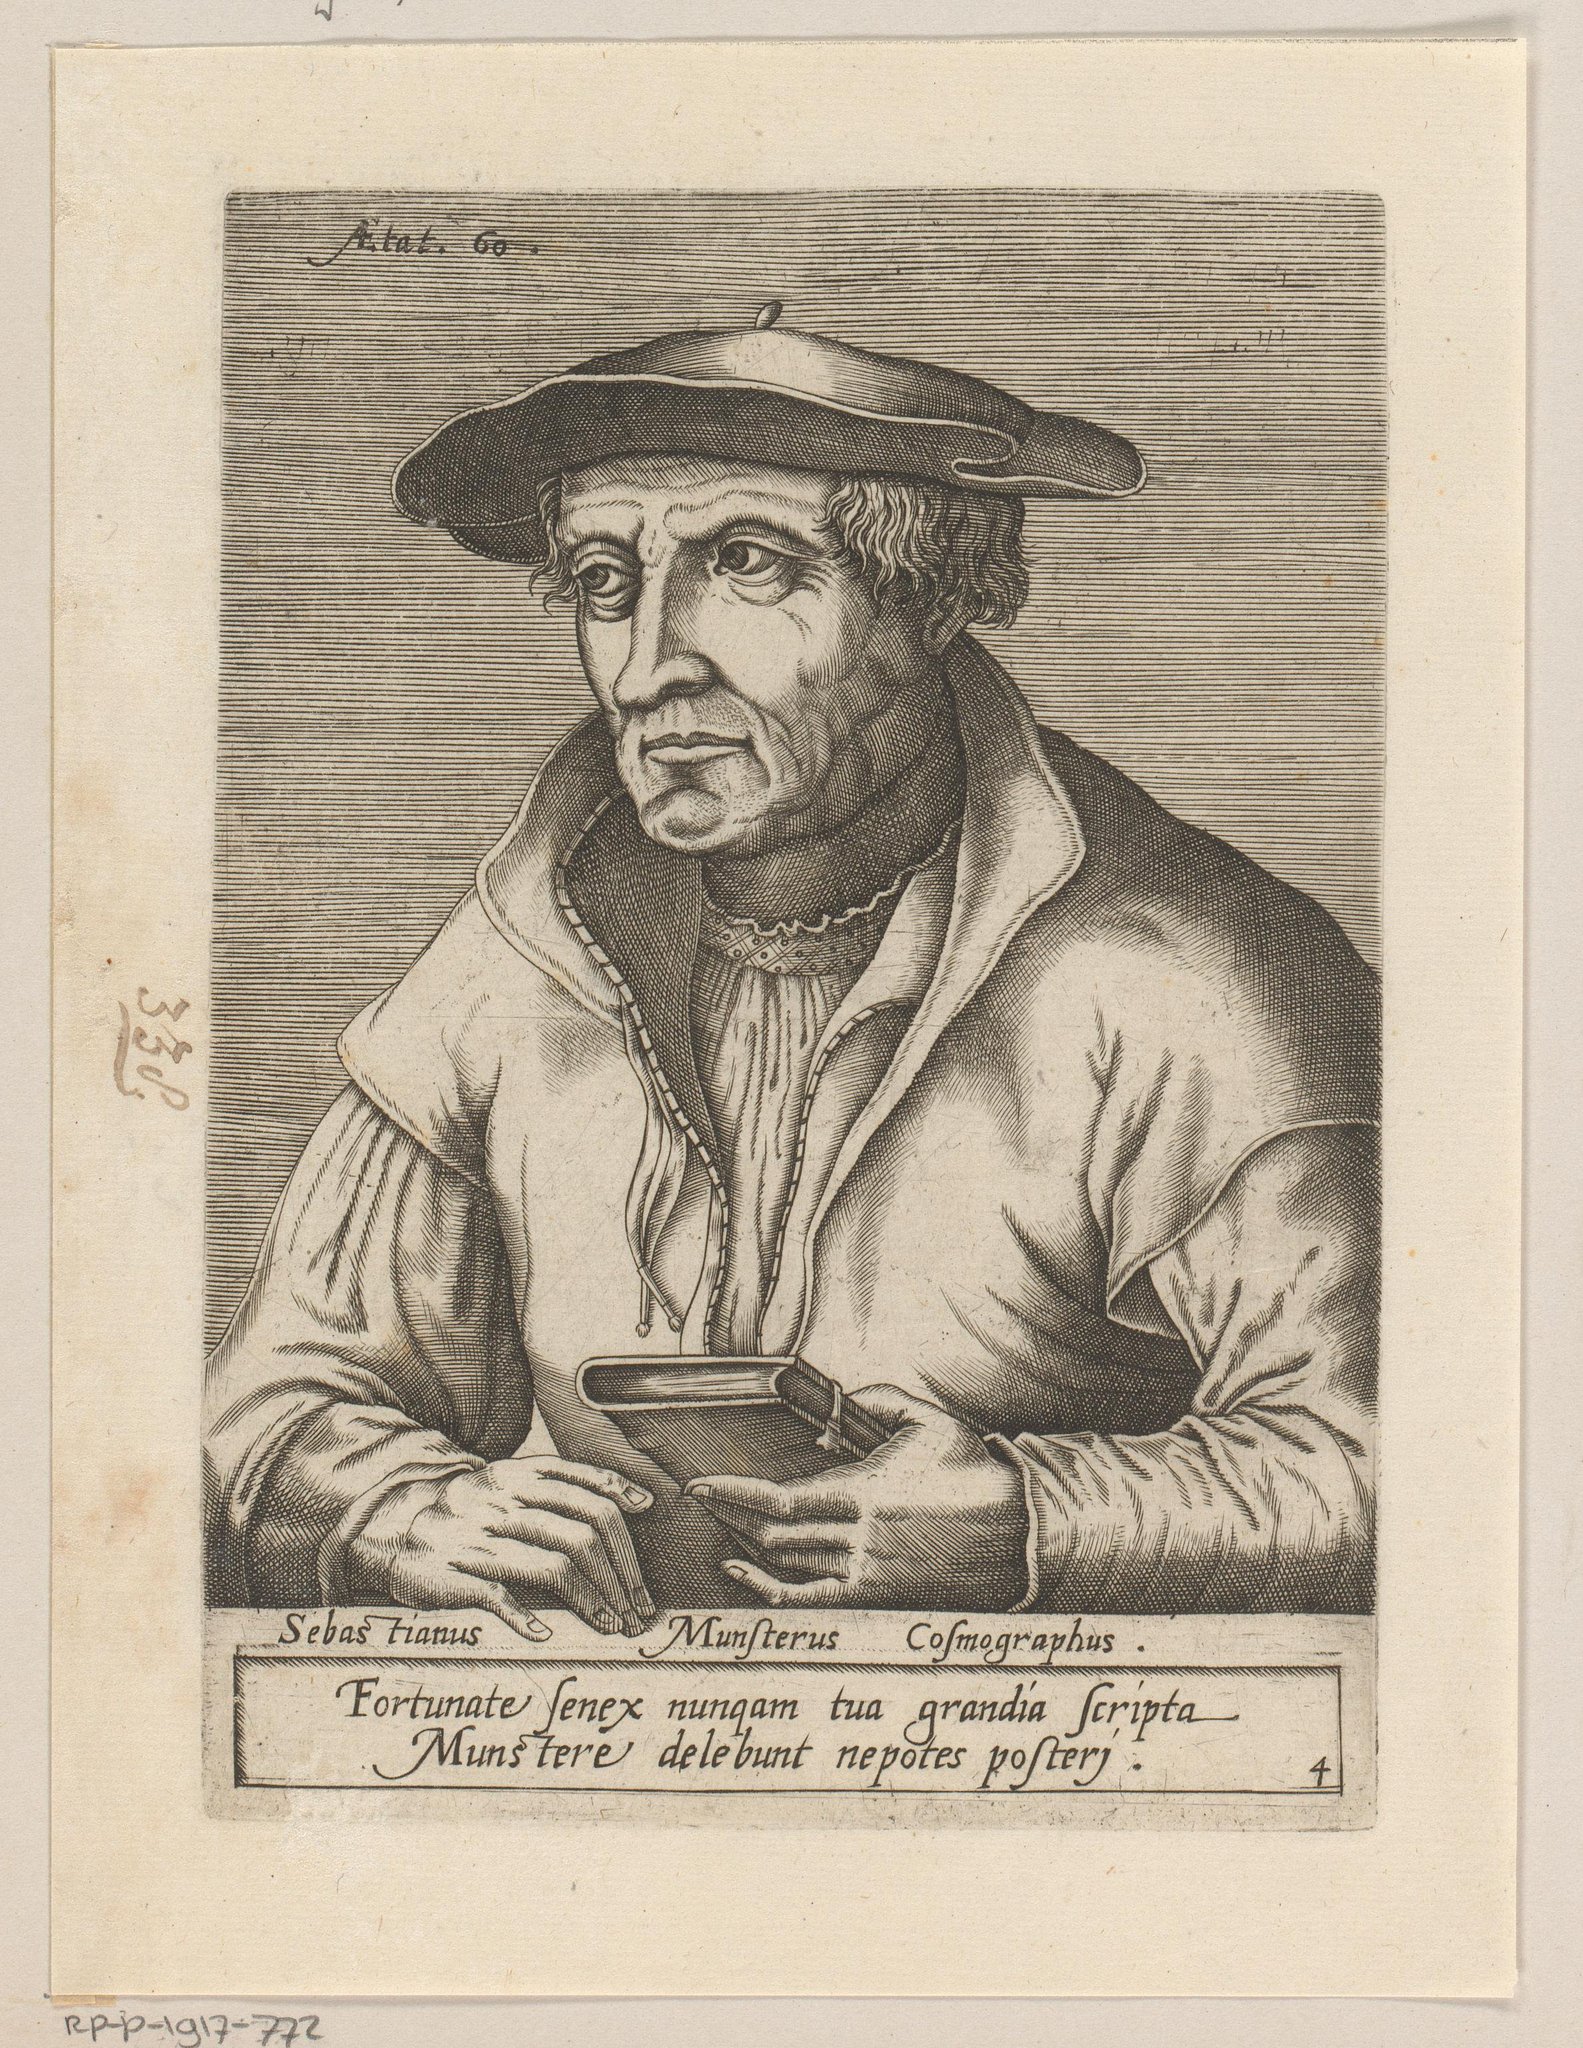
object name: print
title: Sebastianus Munsterus Cosmographus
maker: Anonymous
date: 1548-1650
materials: paper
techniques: engraving, intaglio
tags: scholar, philosopher, historical persons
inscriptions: collector's mark: Lugt 2228, number: ‘338’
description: Met tweeregelig onderschrift in het Latijn. Rechtsonder: 4.